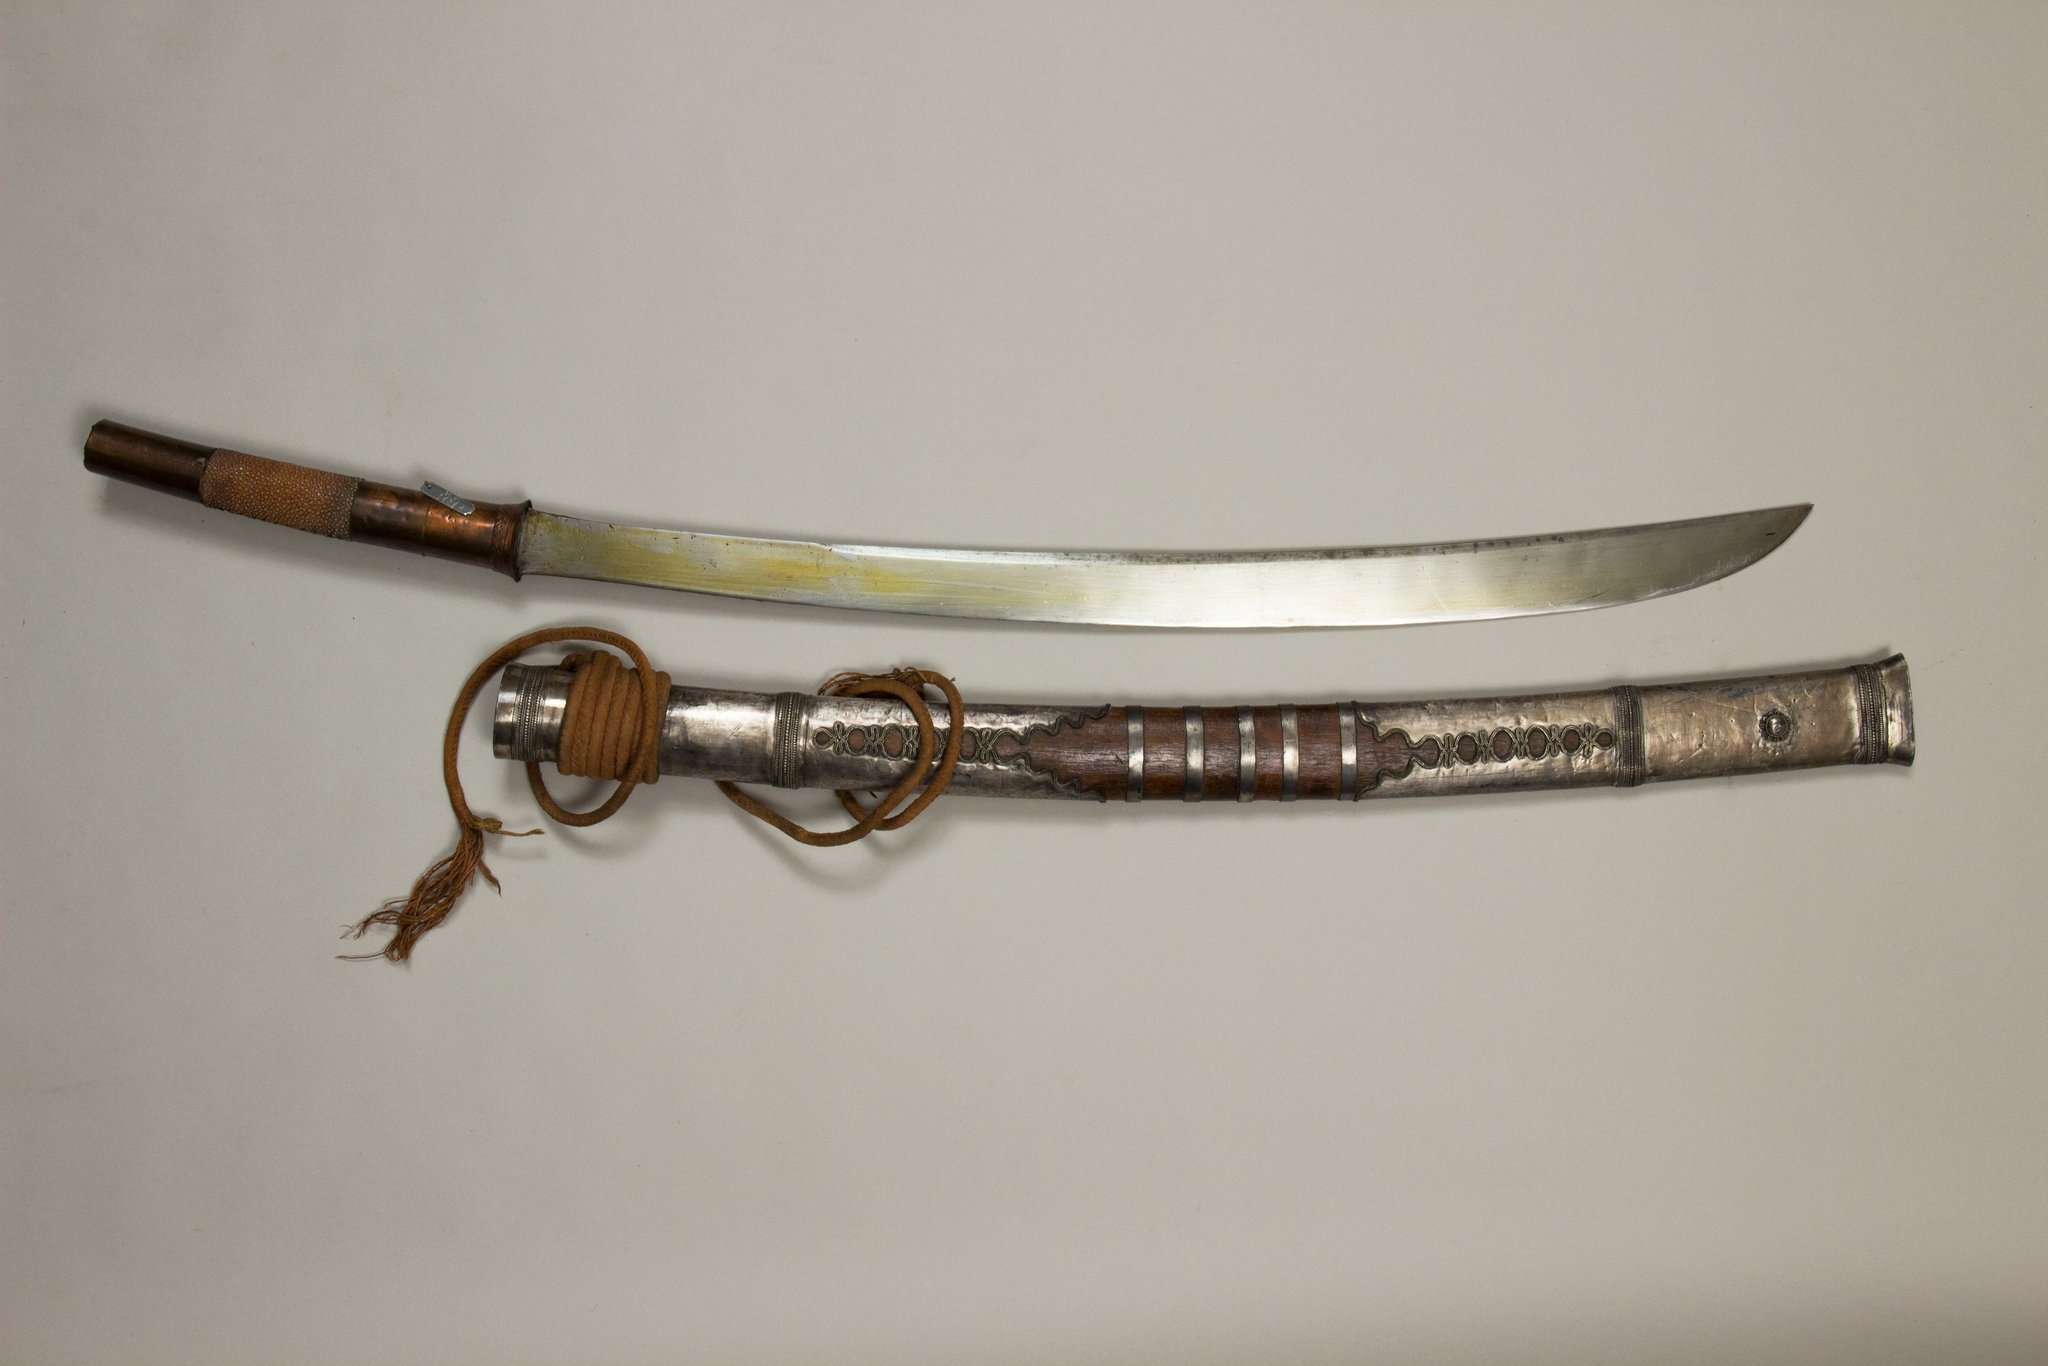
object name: sword dha with scabbard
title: Sword (Dha) with Scabbard and Baldric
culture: burmese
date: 1801-1900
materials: copper, silver, skin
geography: burma